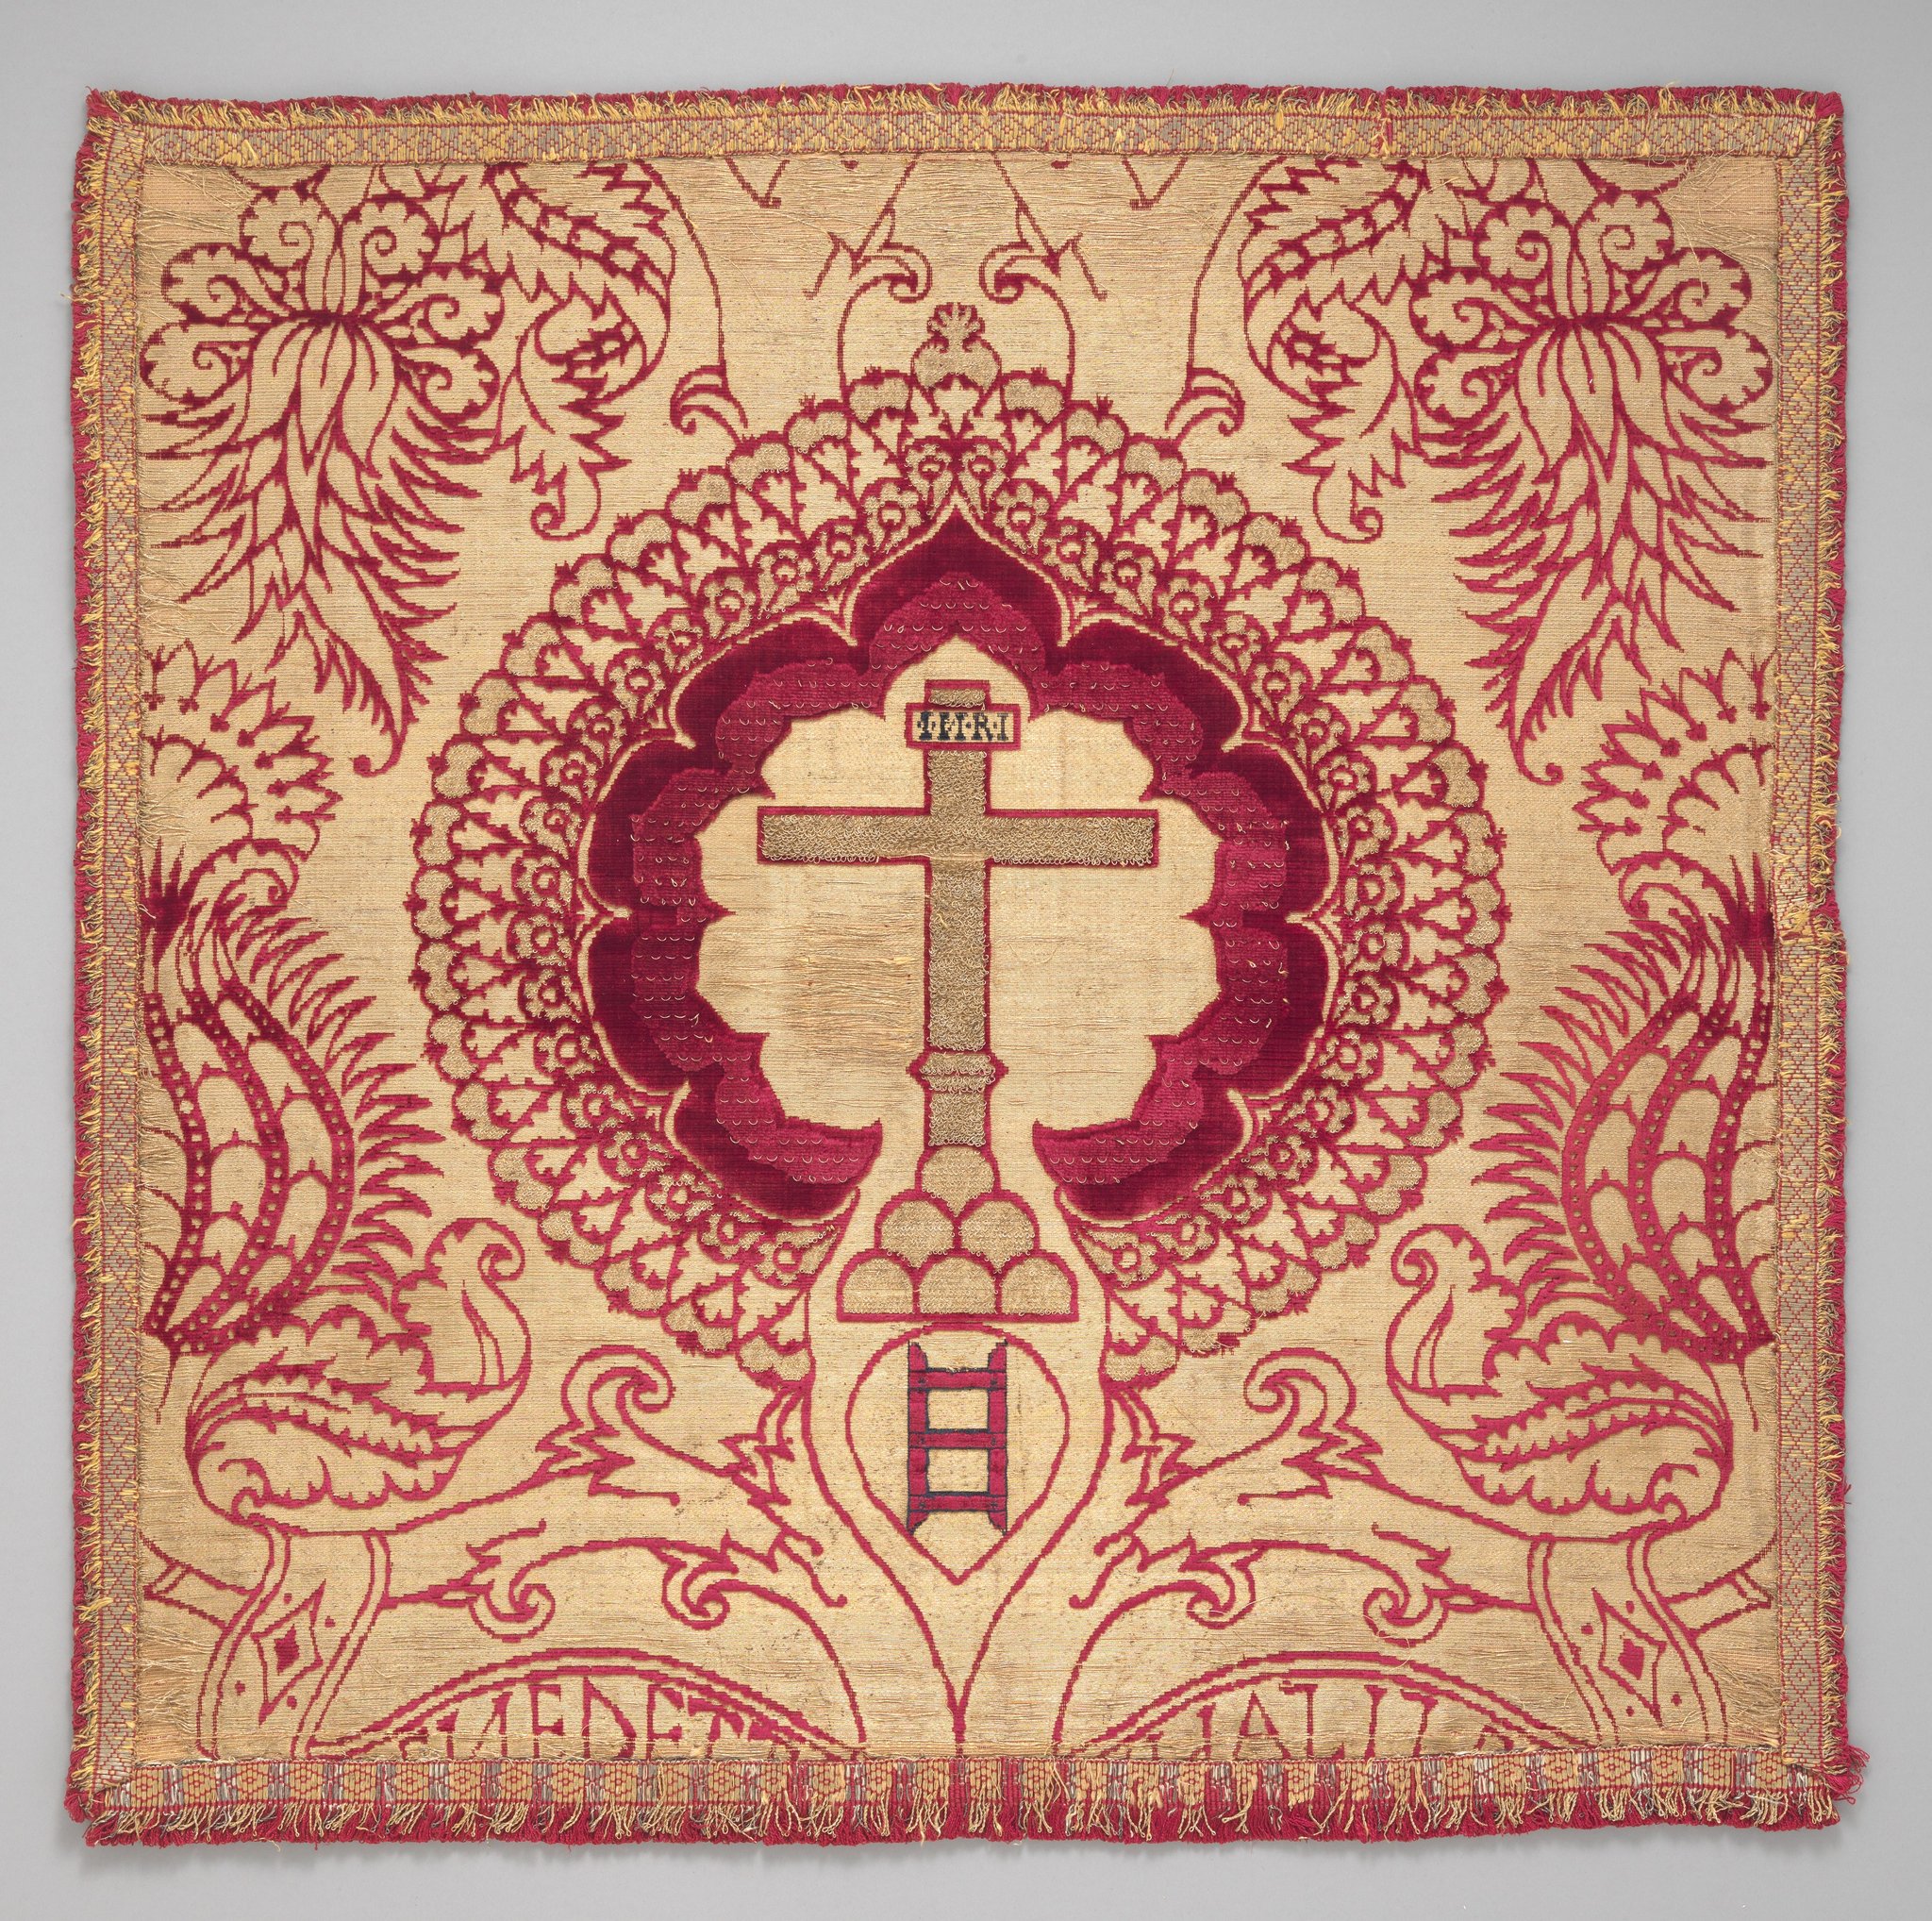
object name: piece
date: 1451-1500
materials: metal thread, silk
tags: cross